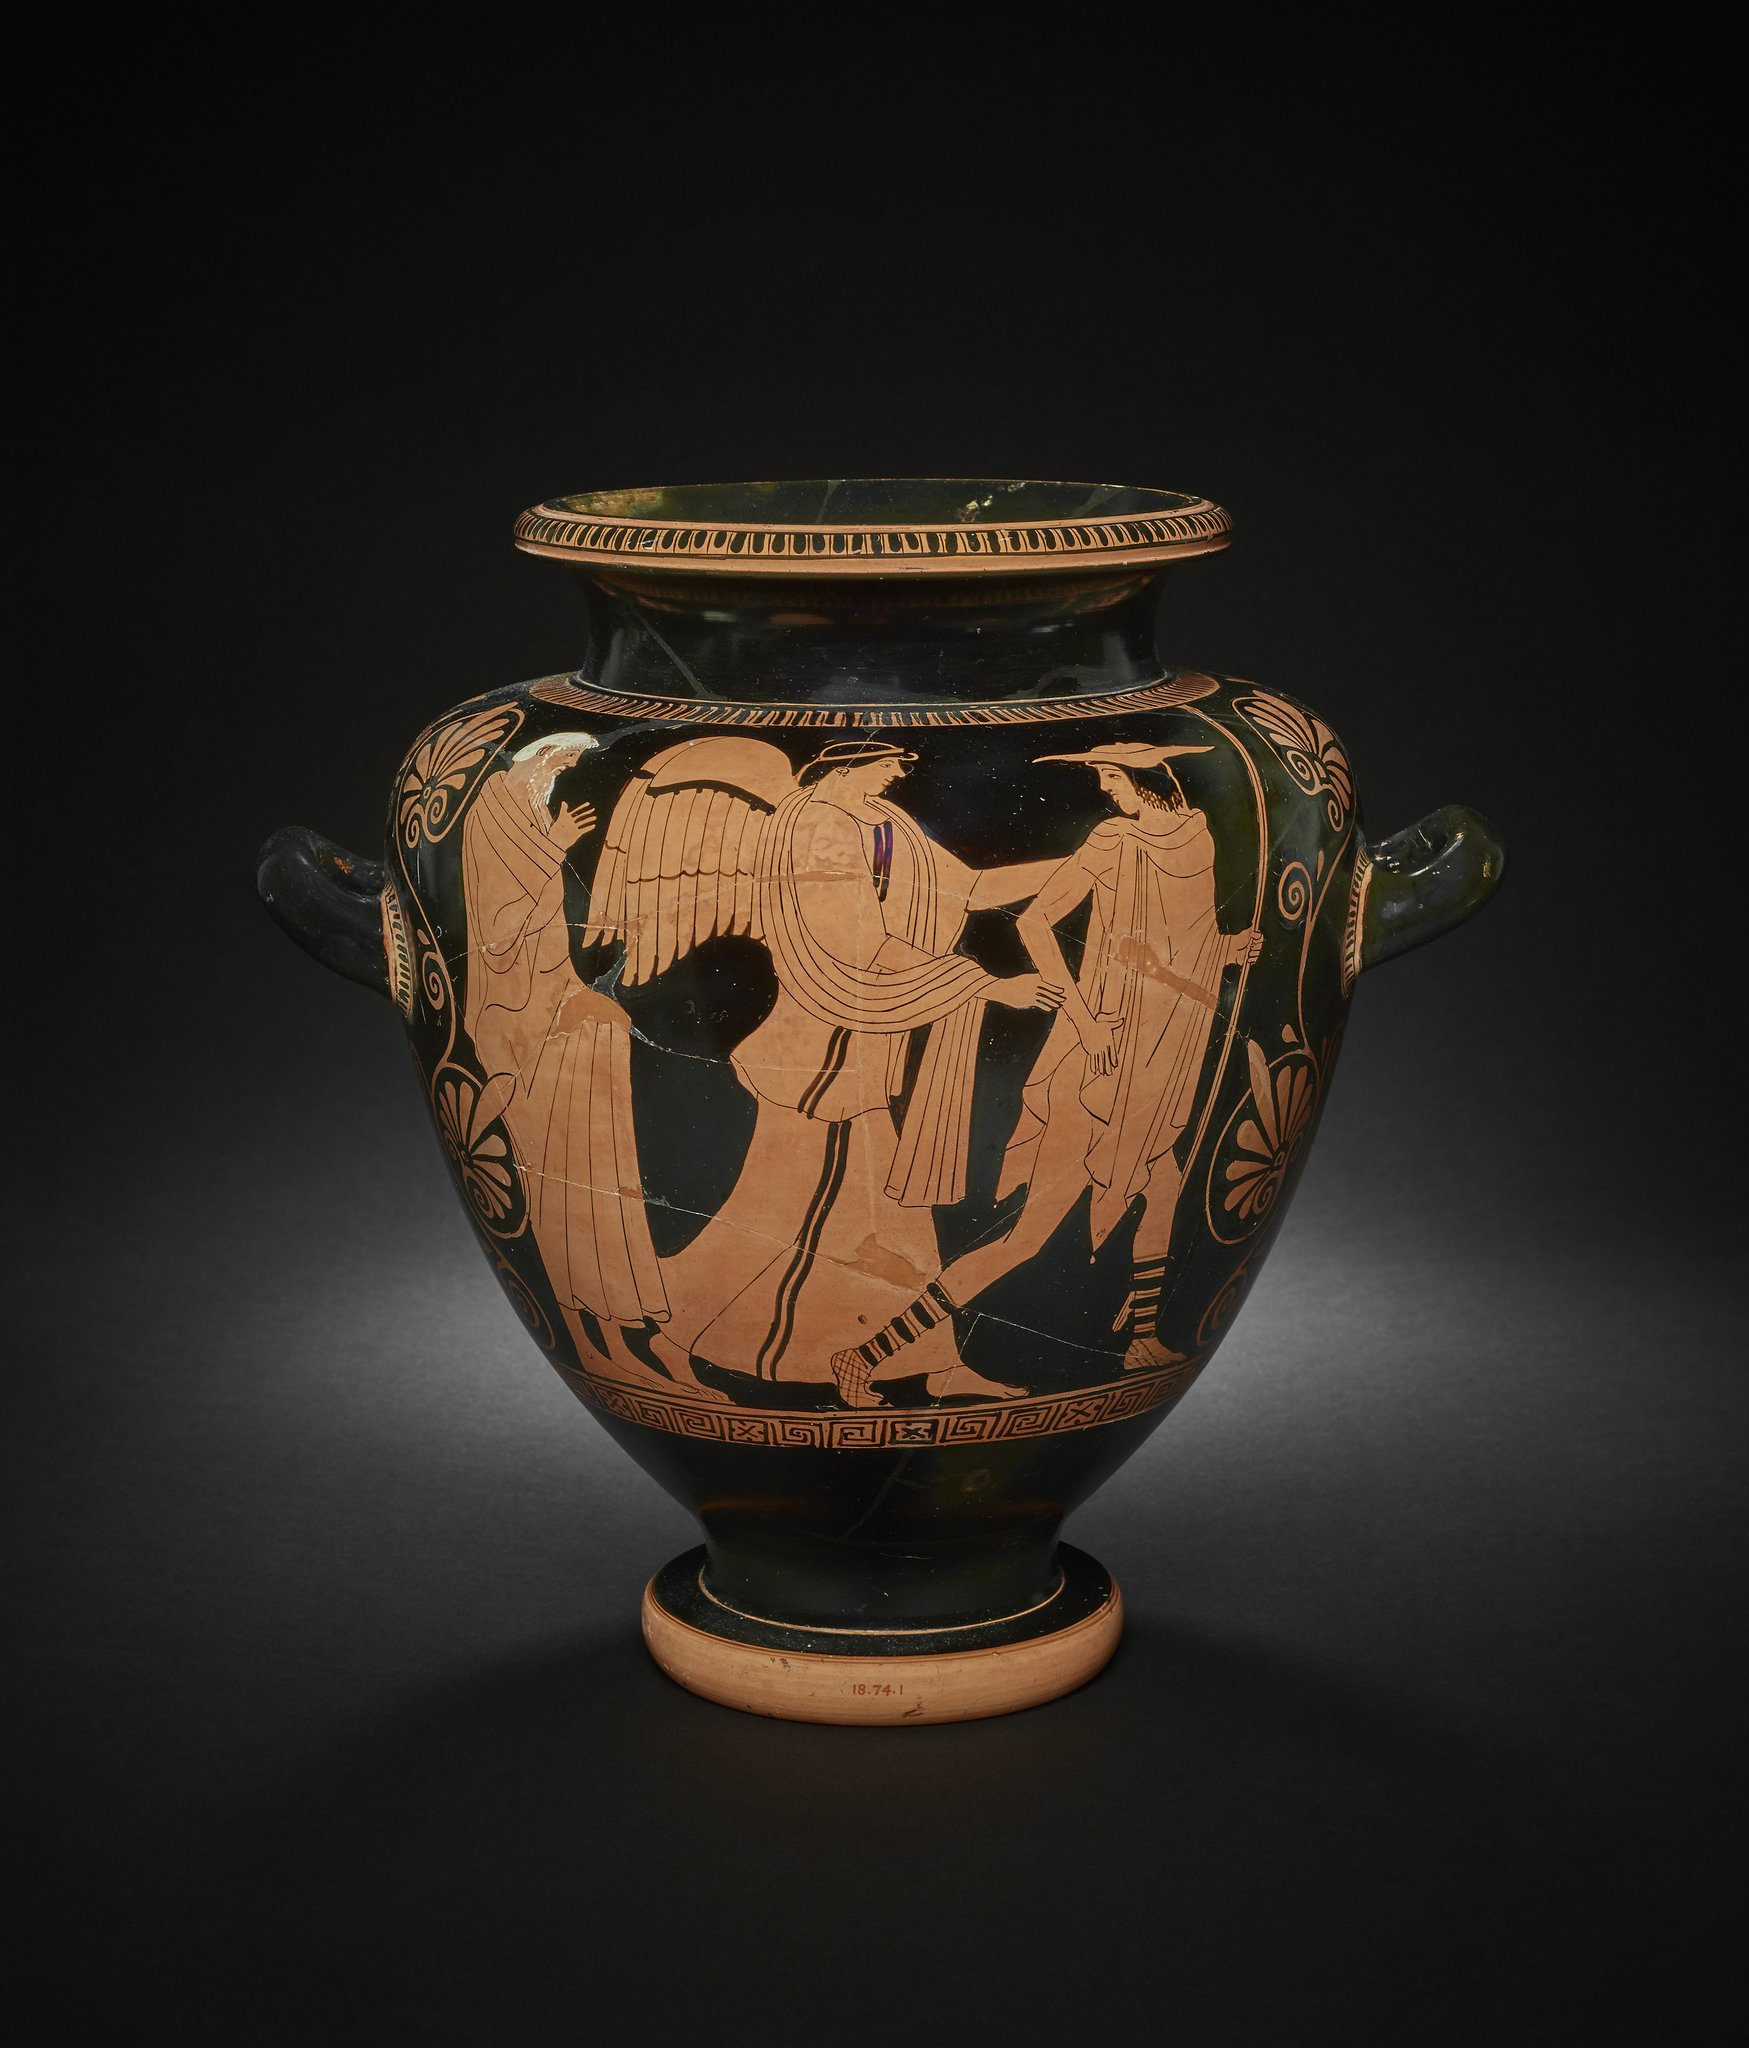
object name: stamnos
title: Terracotta stamnos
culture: greek, attic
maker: deepdene painter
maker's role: artist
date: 470-460 BCE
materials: terracotta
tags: spears,men,women,eos